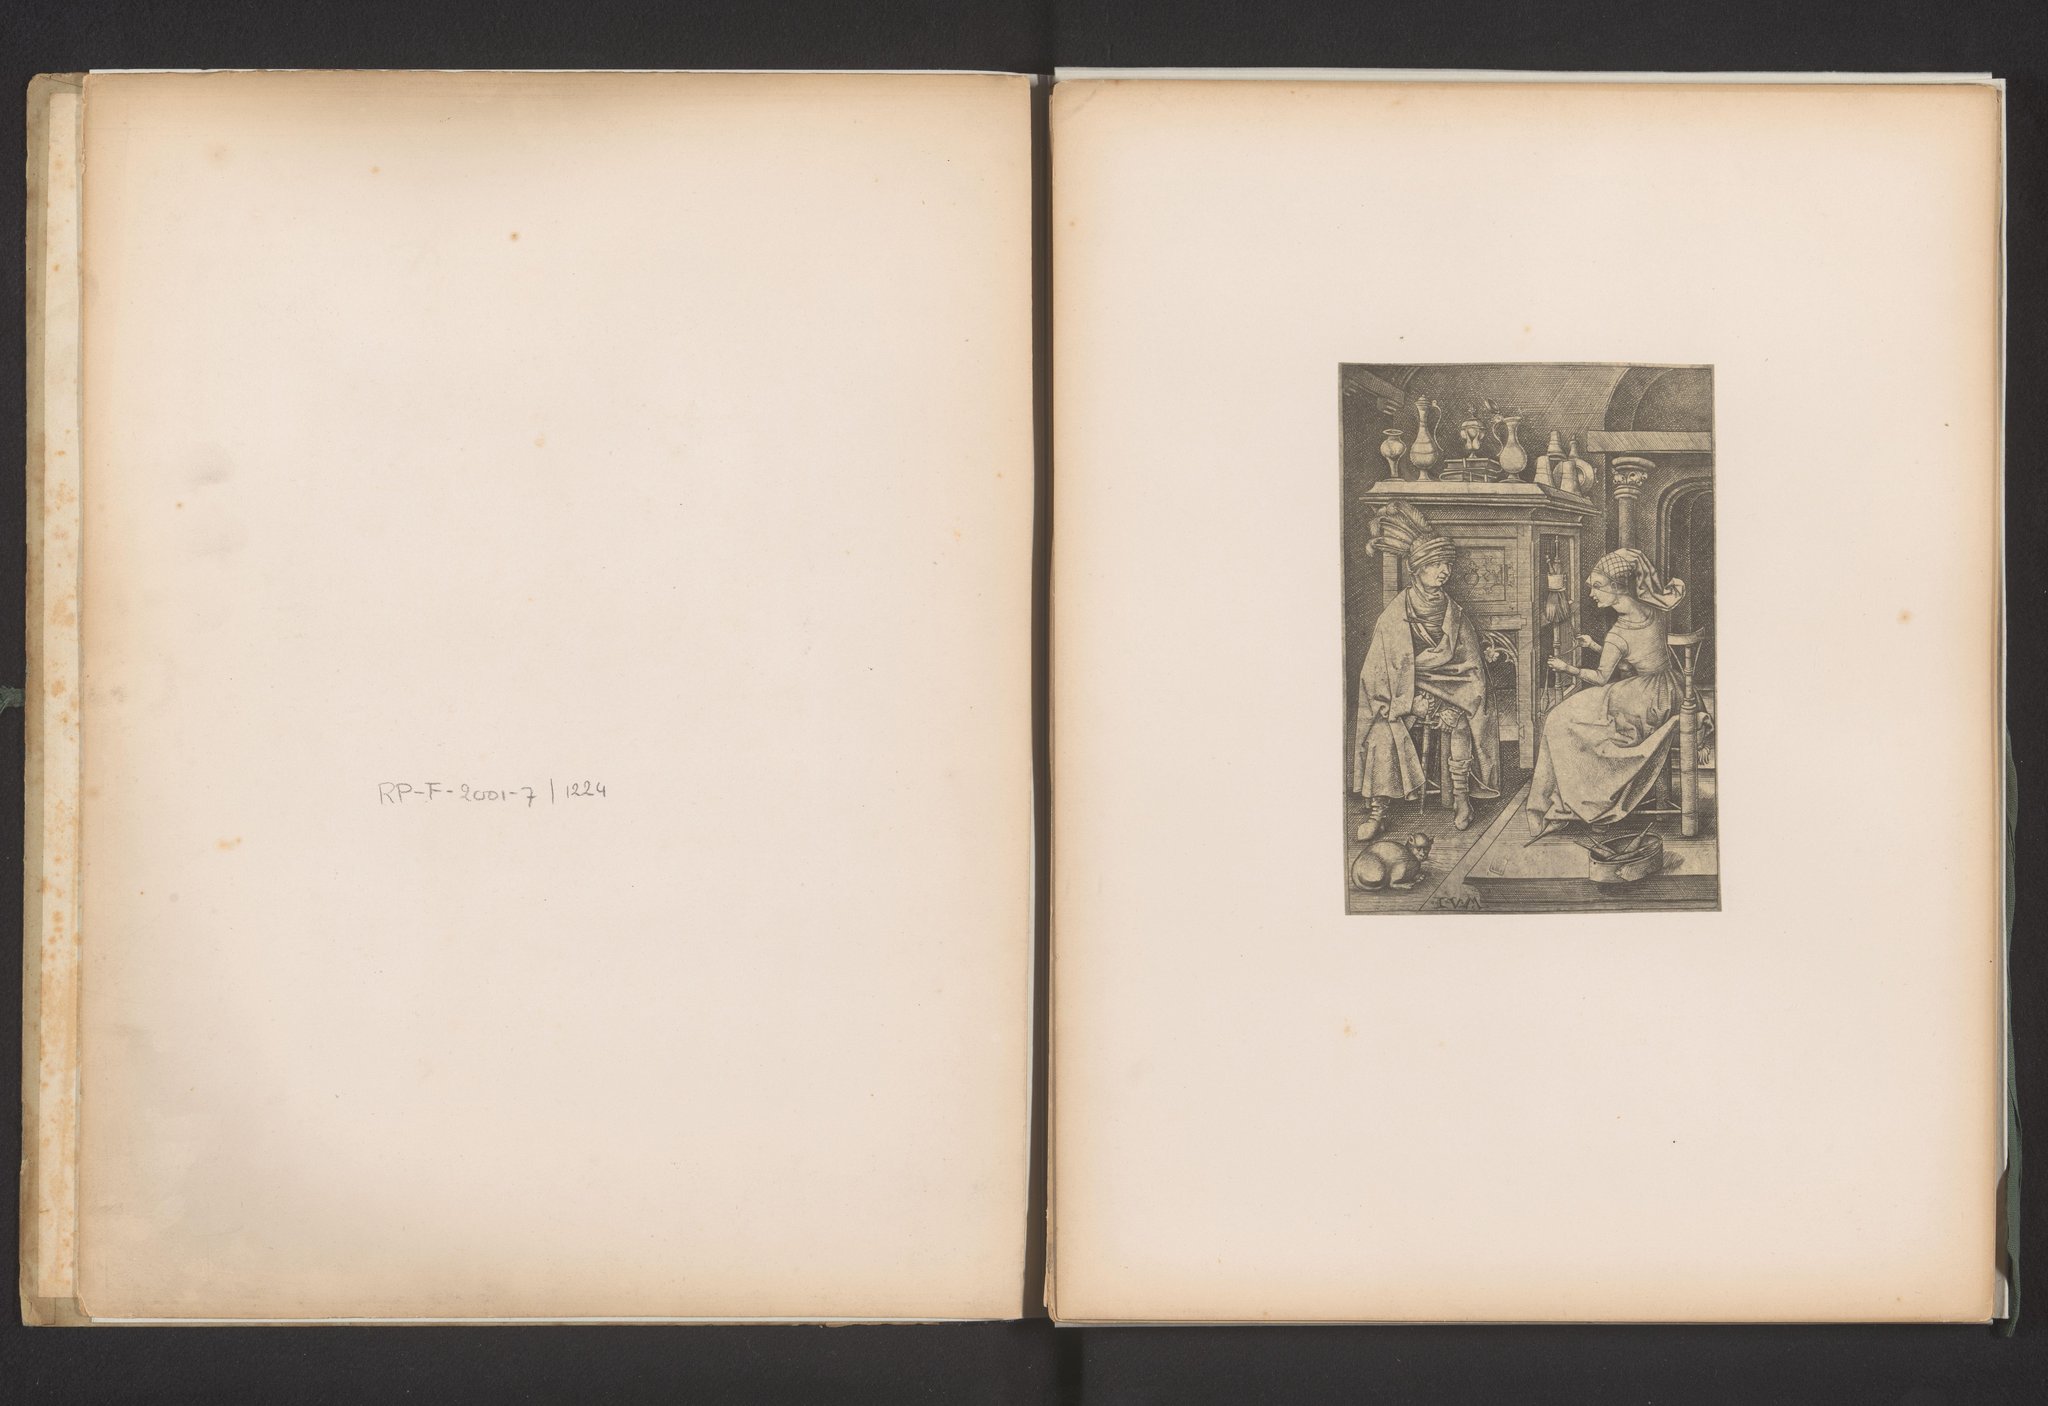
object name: reproduction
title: Reproductie van een prent van een bezoek aan de spinner door Israhel van Meckenem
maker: israhel van meckenem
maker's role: print maker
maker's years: 1440-1517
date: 1867-1872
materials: paper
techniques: woodburytype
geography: brussels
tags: adult woman, adult man, spinning (manufacture of yarn)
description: Deze prent maakt deel uit van een omslag met 12 prenten op 12 bladen.